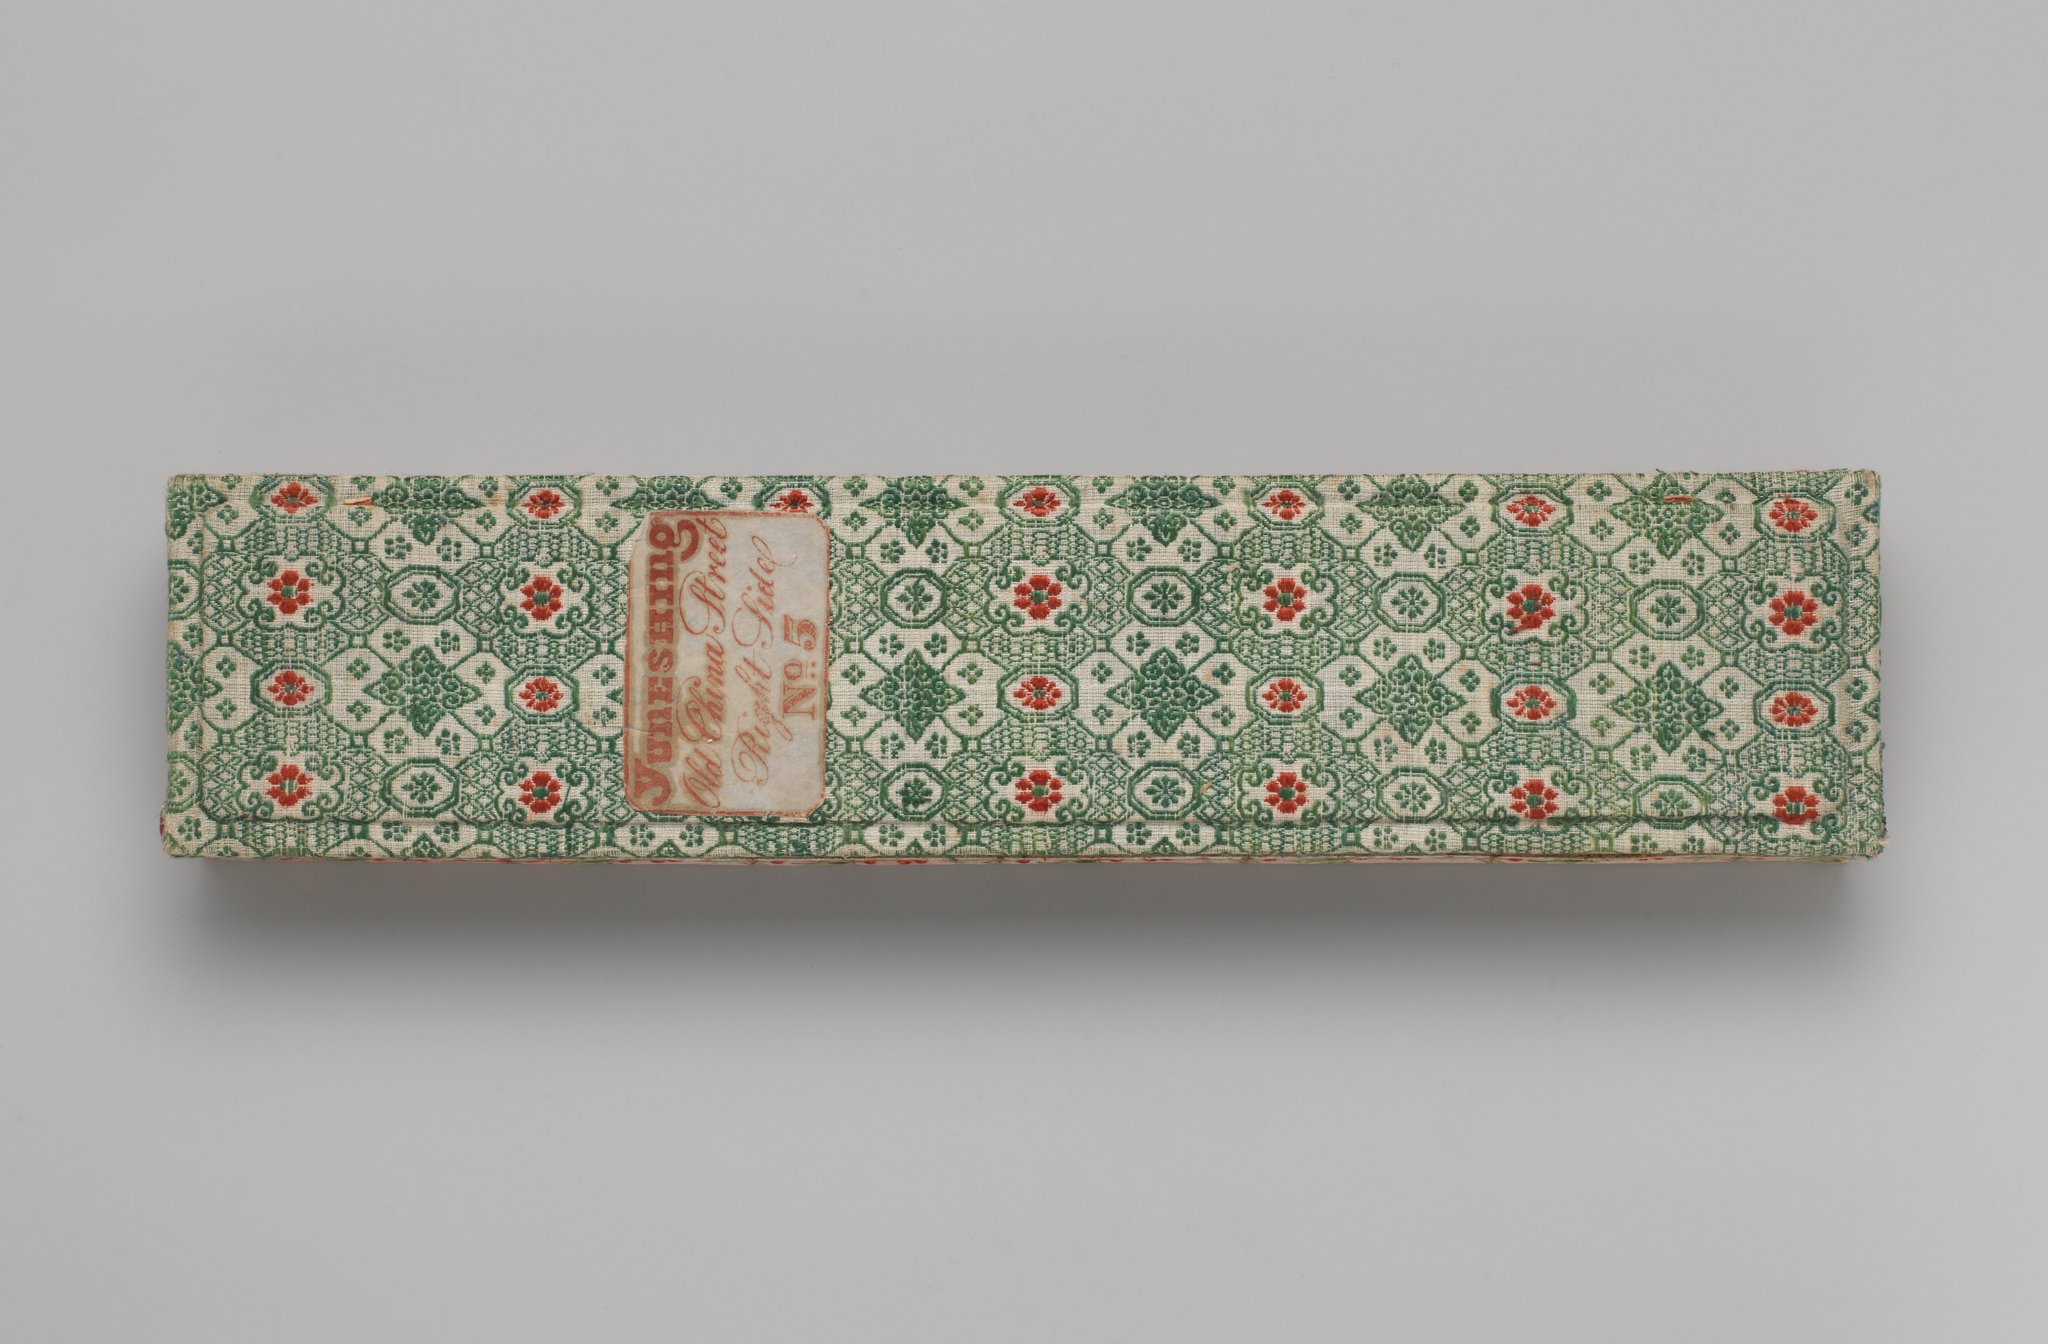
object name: fan box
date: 1801-1850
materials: cardboard, textile